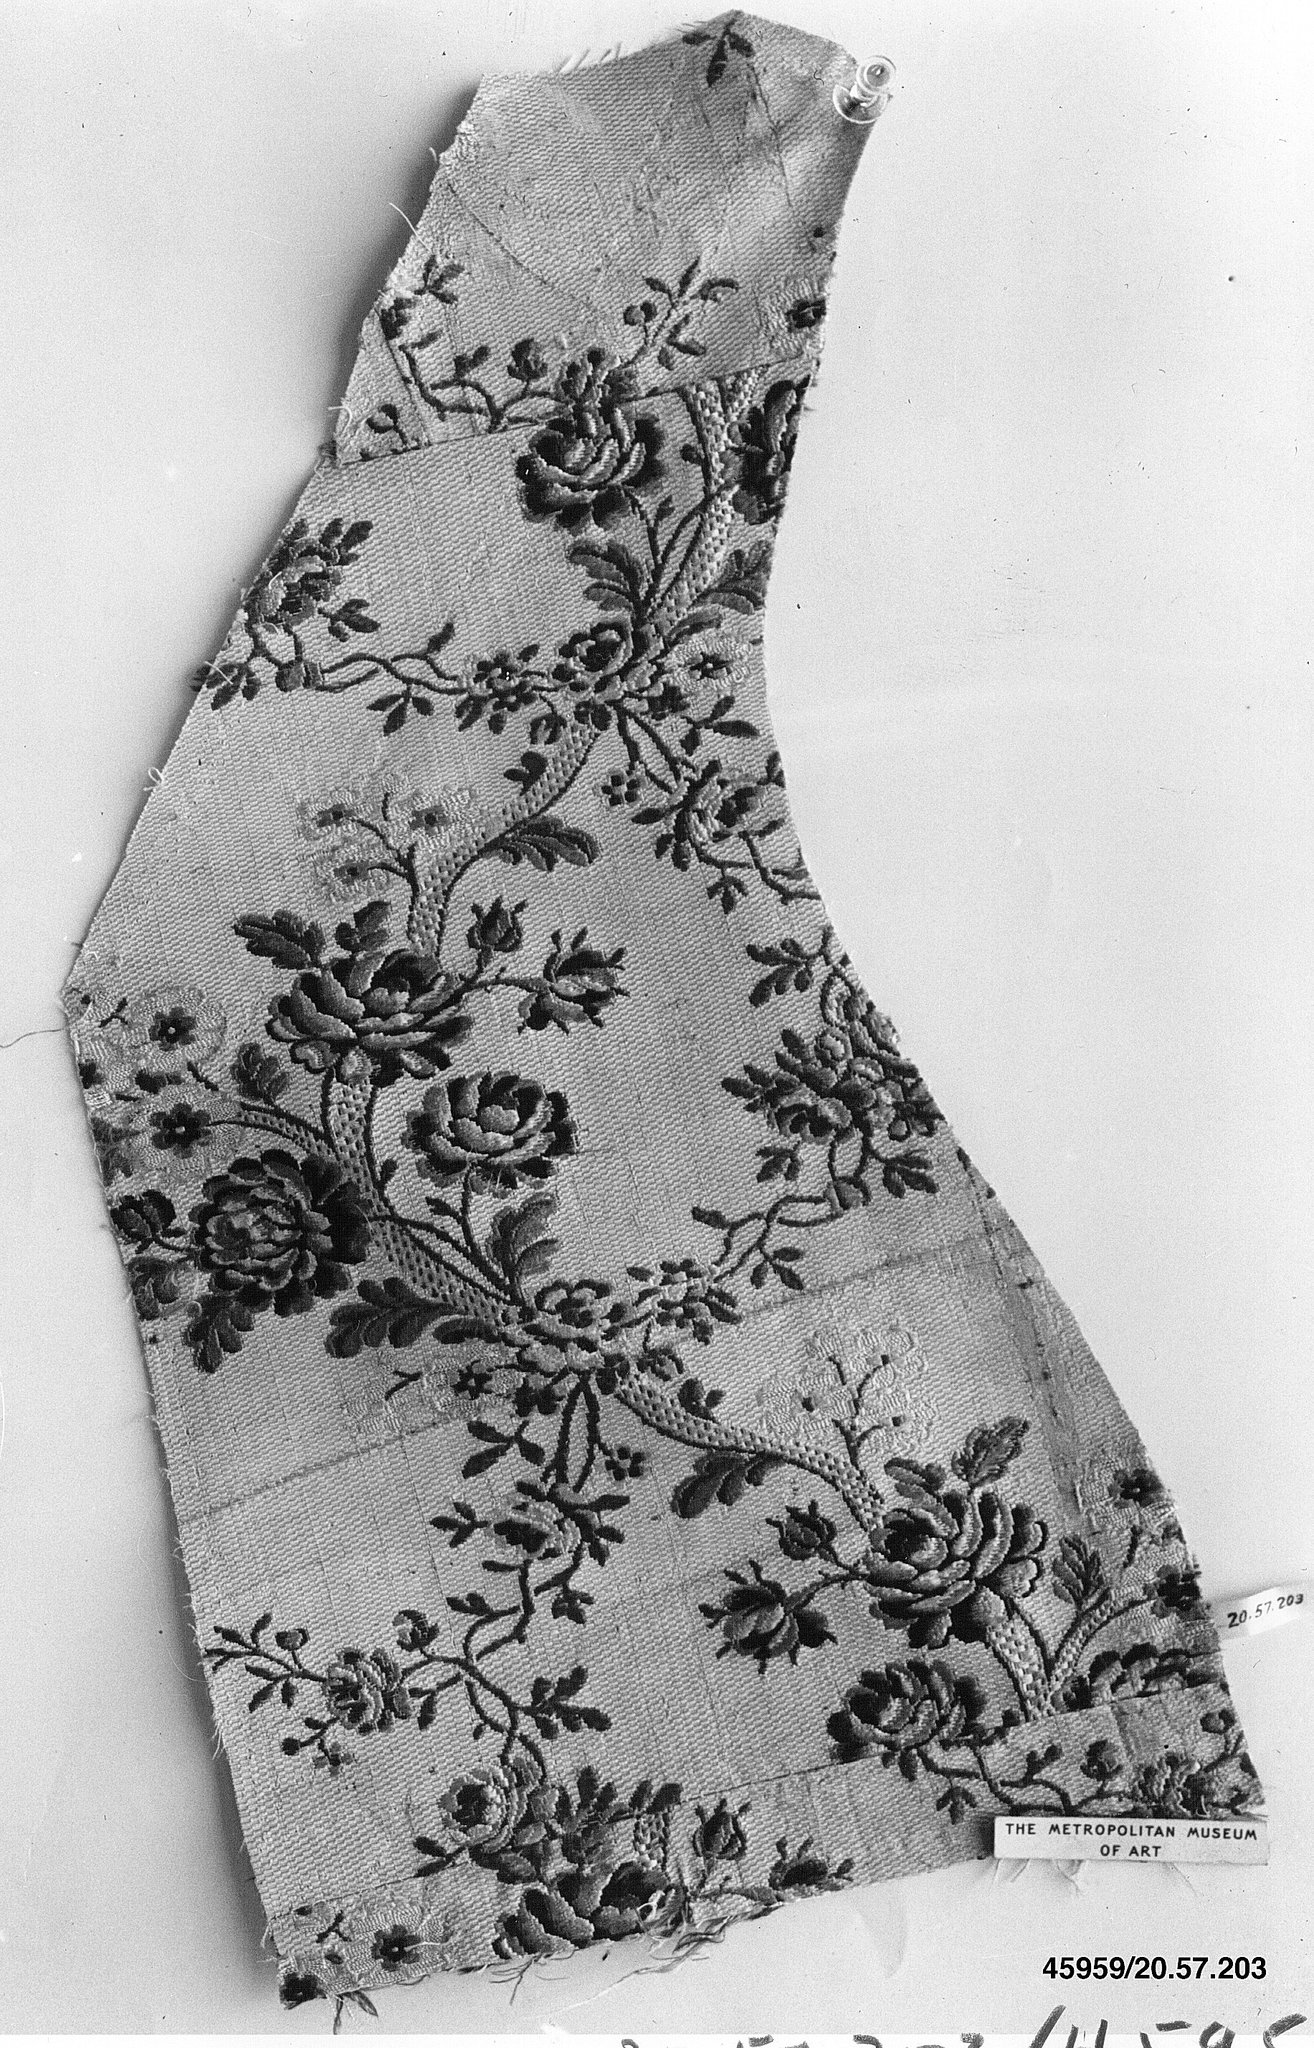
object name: piece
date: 1750-1760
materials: silk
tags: flowers,leaves